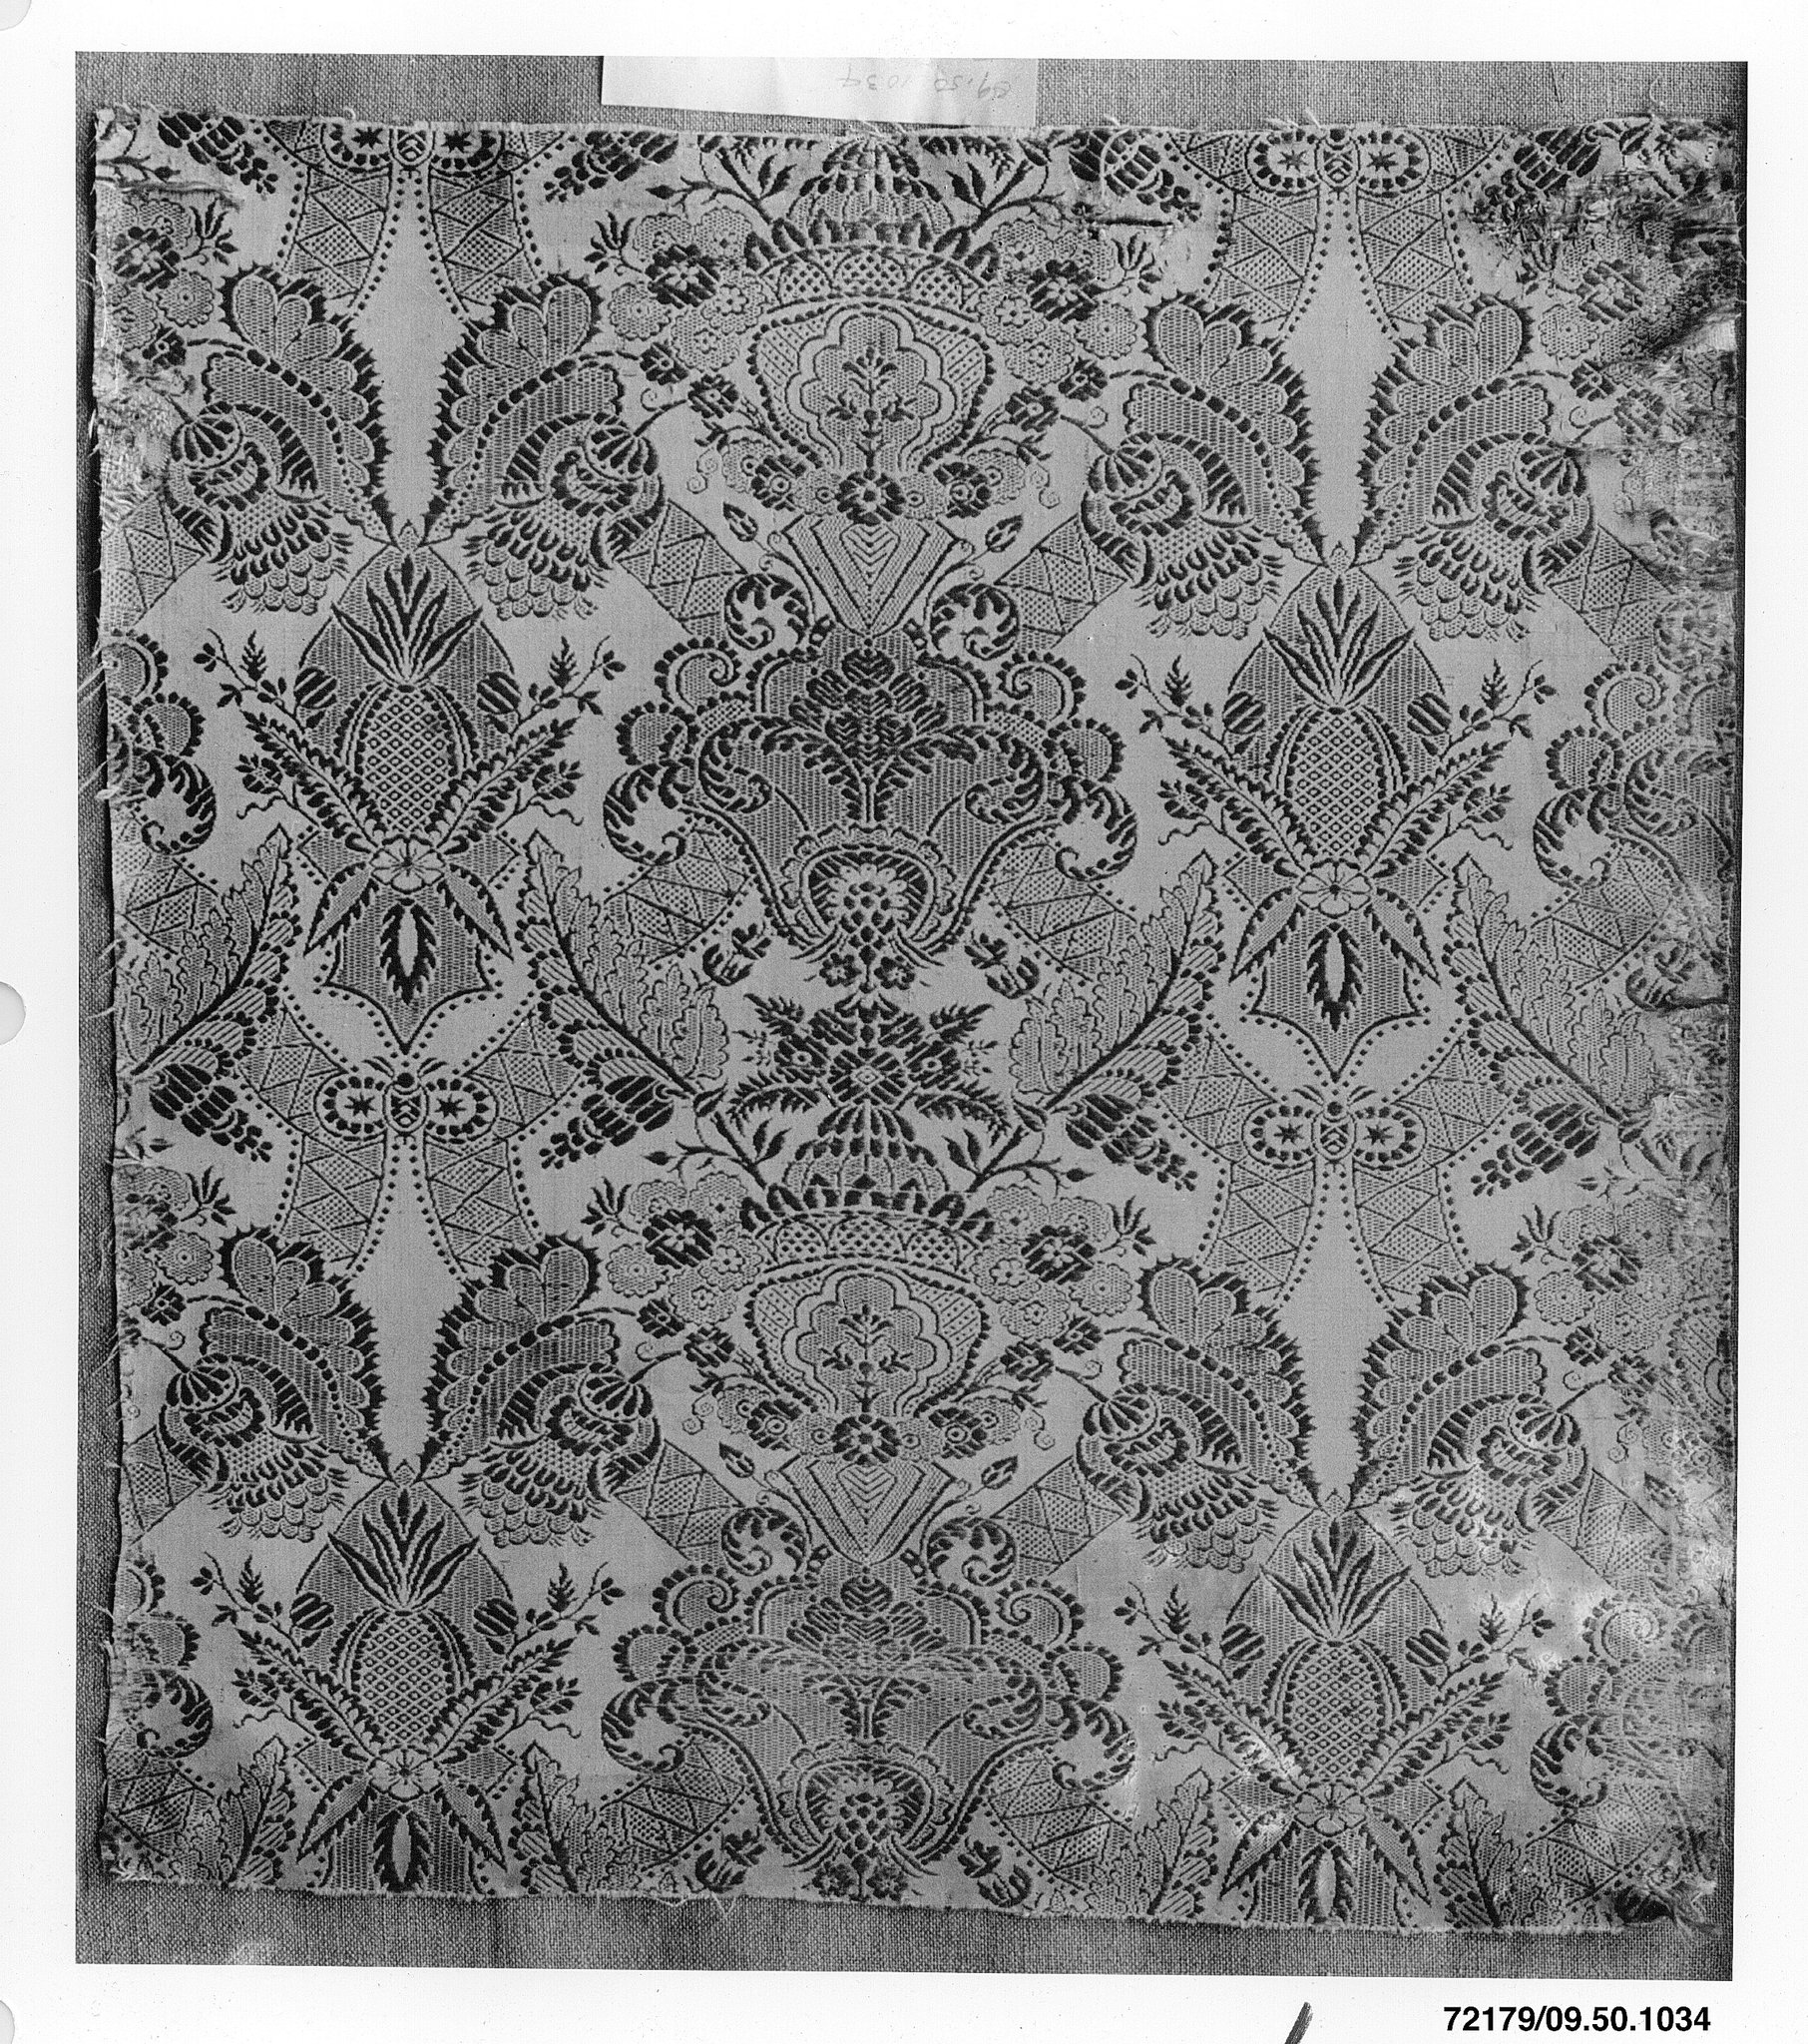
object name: piece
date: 1720-1730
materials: silk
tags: leaves